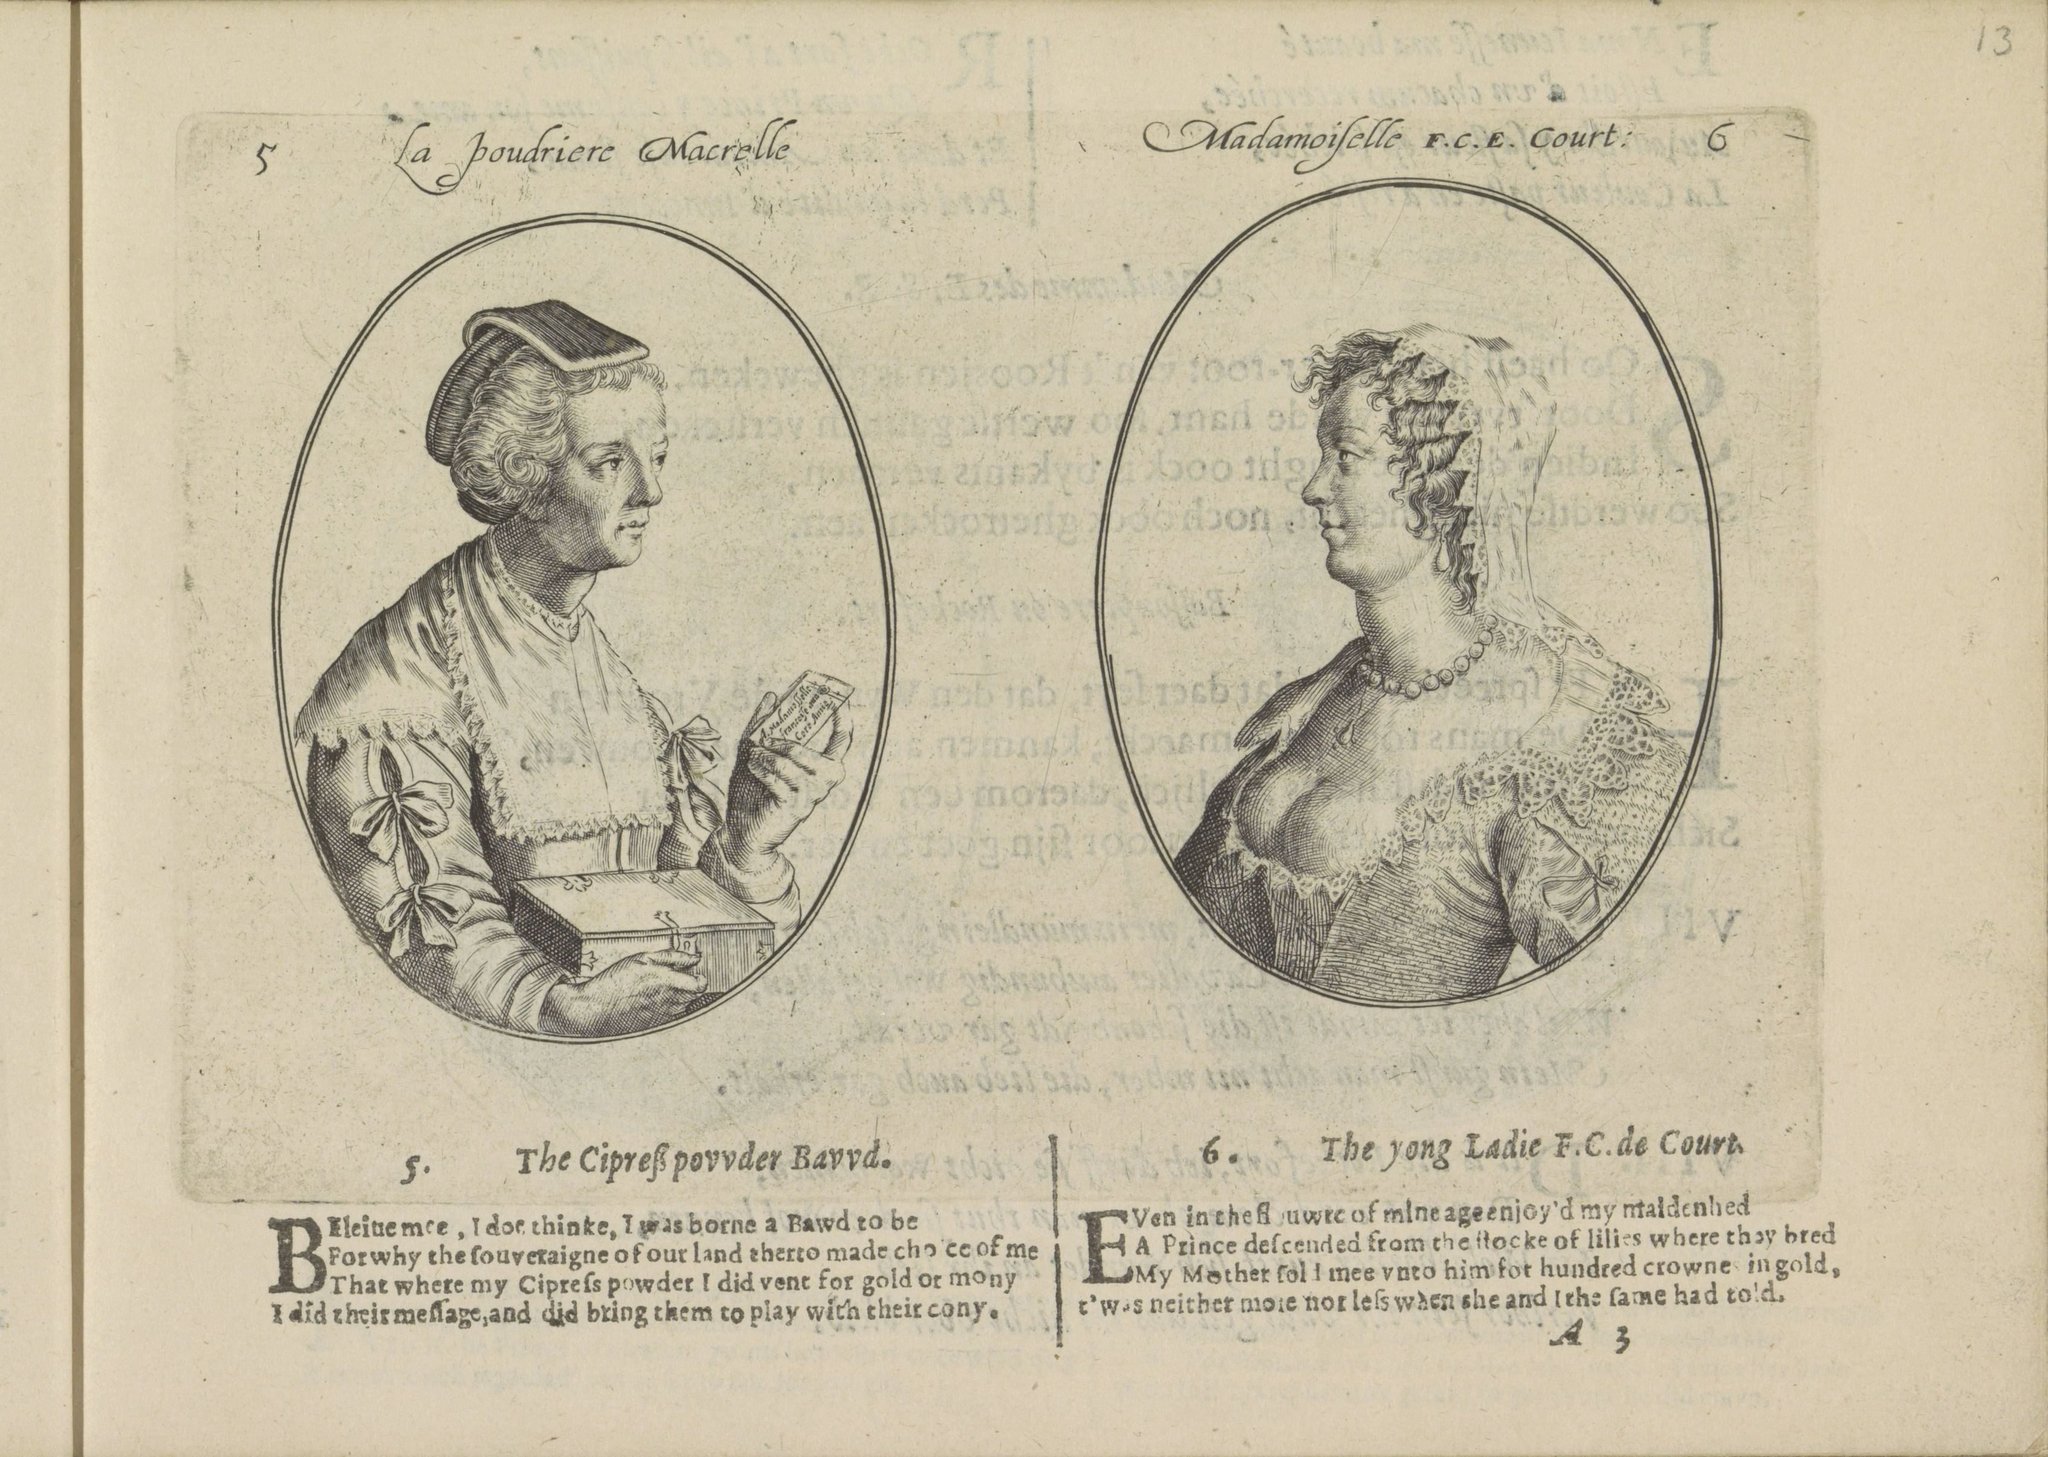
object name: album leaf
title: Portretten van de koppelaarster La Poudriere Macrelle en de courtisane Madamoiselle F.C.E. de Court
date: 1635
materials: paper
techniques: engraving, letterpress printing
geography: utrecht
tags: herding, herdsman, herdswoman, shepherd, shepherdess, cowherd, etc.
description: Twee voorstellingen op een albumblad. Links de courtisane La poudriere Macrelle. Zij heeft een doos bij zich en een kaartje met de boodschap: a madamoiselle Françoise ma chere amie. Rechts Madamoiselle F.C.E. de Court. Daaronder twee kwatrijnen in het Engels. Het blad maakt deel uit van een album.